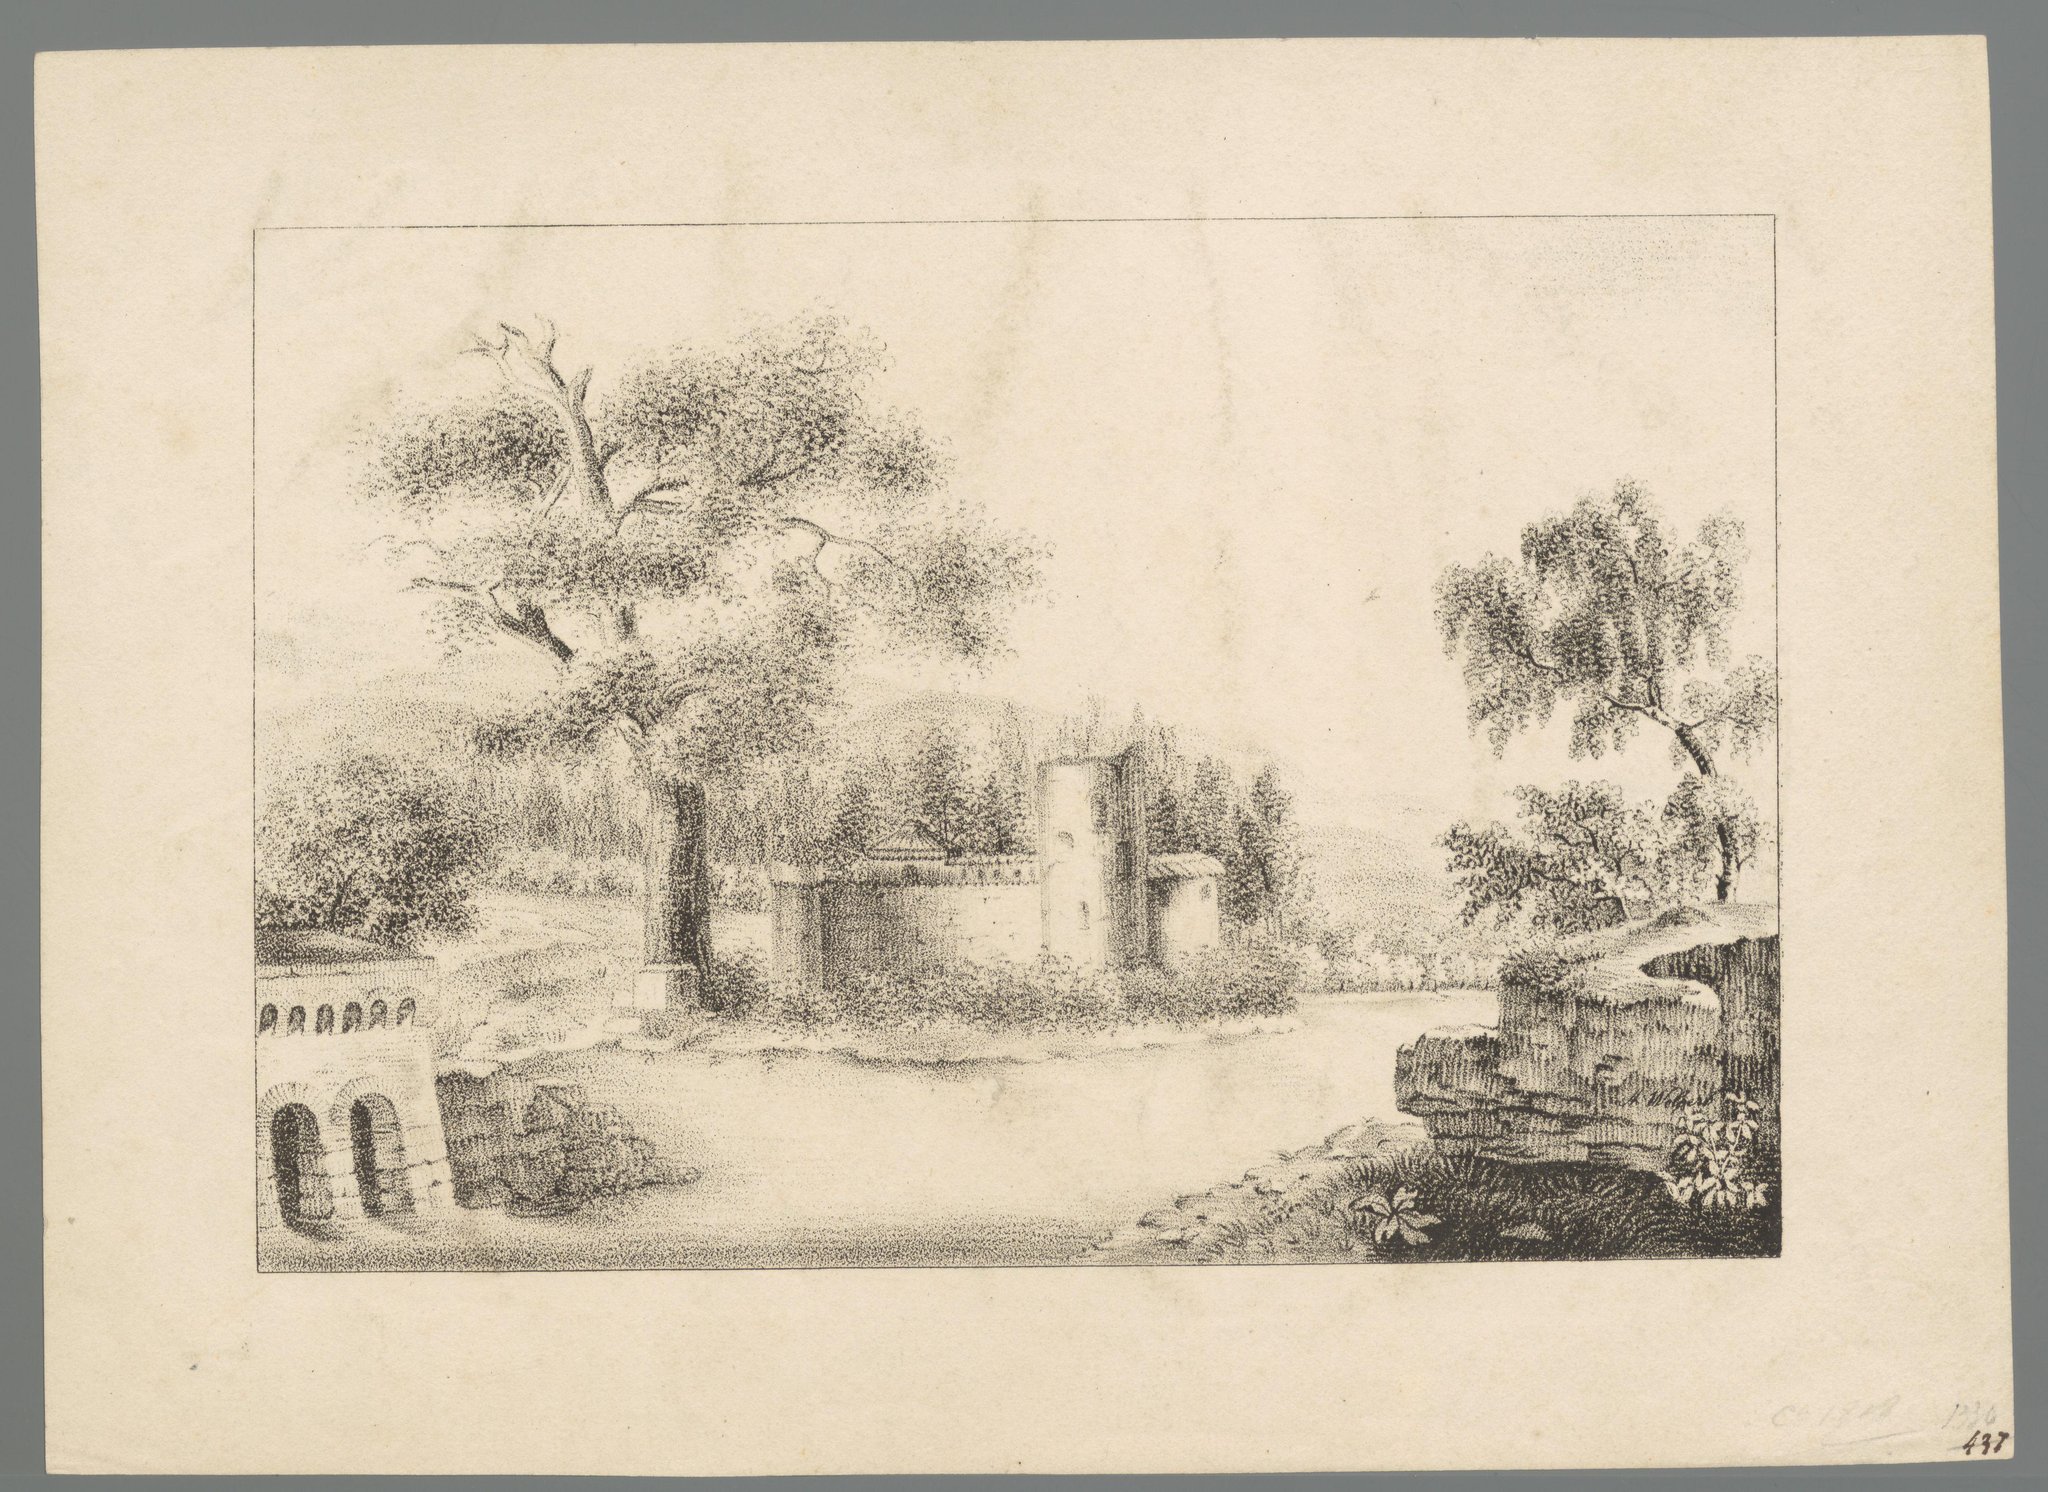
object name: print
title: Landschap met kasteel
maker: Anonymous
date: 1810-1860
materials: paper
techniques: lithograph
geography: germany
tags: water course, landscape with tower or castle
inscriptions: watermark, mark: ‘A. W[e/o]l[g]ers.’, collector's mark: Lugt 2228